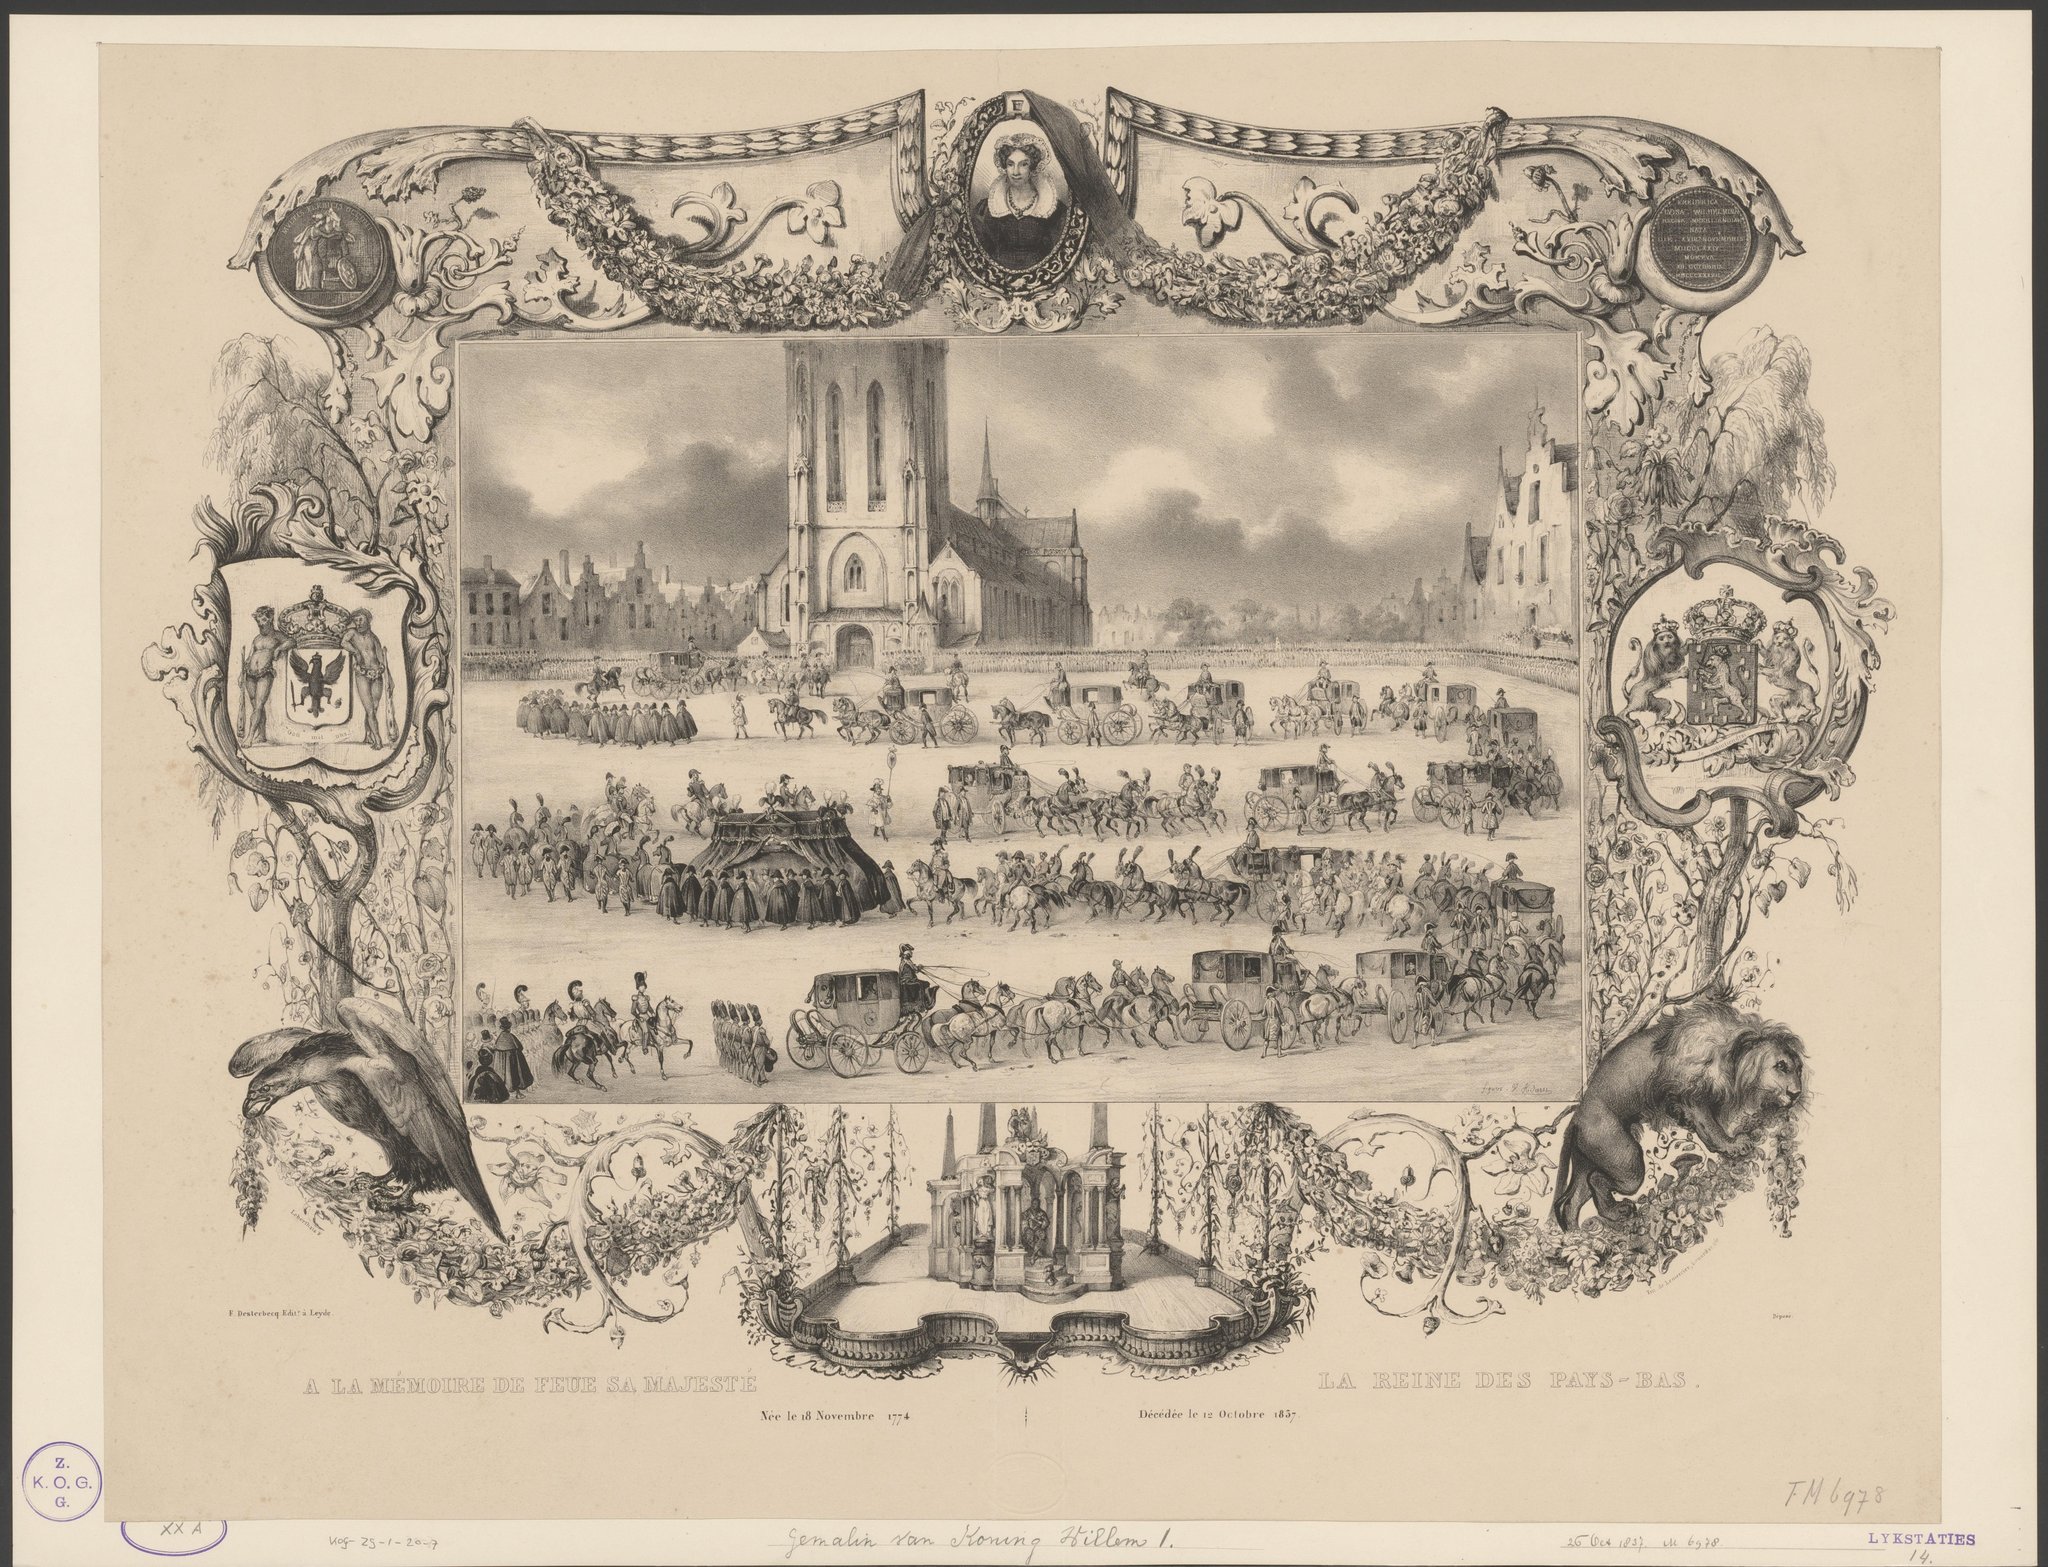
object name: print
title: Begrafenis van koningin Wilhelmina van Pruisen te Delft, 1837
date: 1837-1839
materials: paper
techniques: lithograph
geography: paris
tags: berlin, the hague, wilhelmina frederica louisa (koningin der nederlanden), coat of arms (symbol of sovereignty), the place of worship and its equipment ~ christian churches, historical persons - bb - woman, cortege, funeral procession, grave-building, monumental tomb, delft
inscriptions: collector's mark: Lugt 1641, stamp, : ‘Déposé’, stamp, check stamp: ‘Desterbecq a Leide’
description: Begrafenisstoet op de markt voor de Nieuwe Kerk van Delft van koningin Wilhelmina van Pruisen. Rondom een versierde lijst met het portret van de koningin, familiewapens, medaillons, een adelaar, een leeuw en het grafmonument in de Nieuwe Kerk. Onderwerpsrubrieken binnen de Atlas Zeden en Gewoonten: Zeden en Gewoonten in Engeren Zin, Des menschen beging, midden en einde, Vorstelijke lijkstaties.